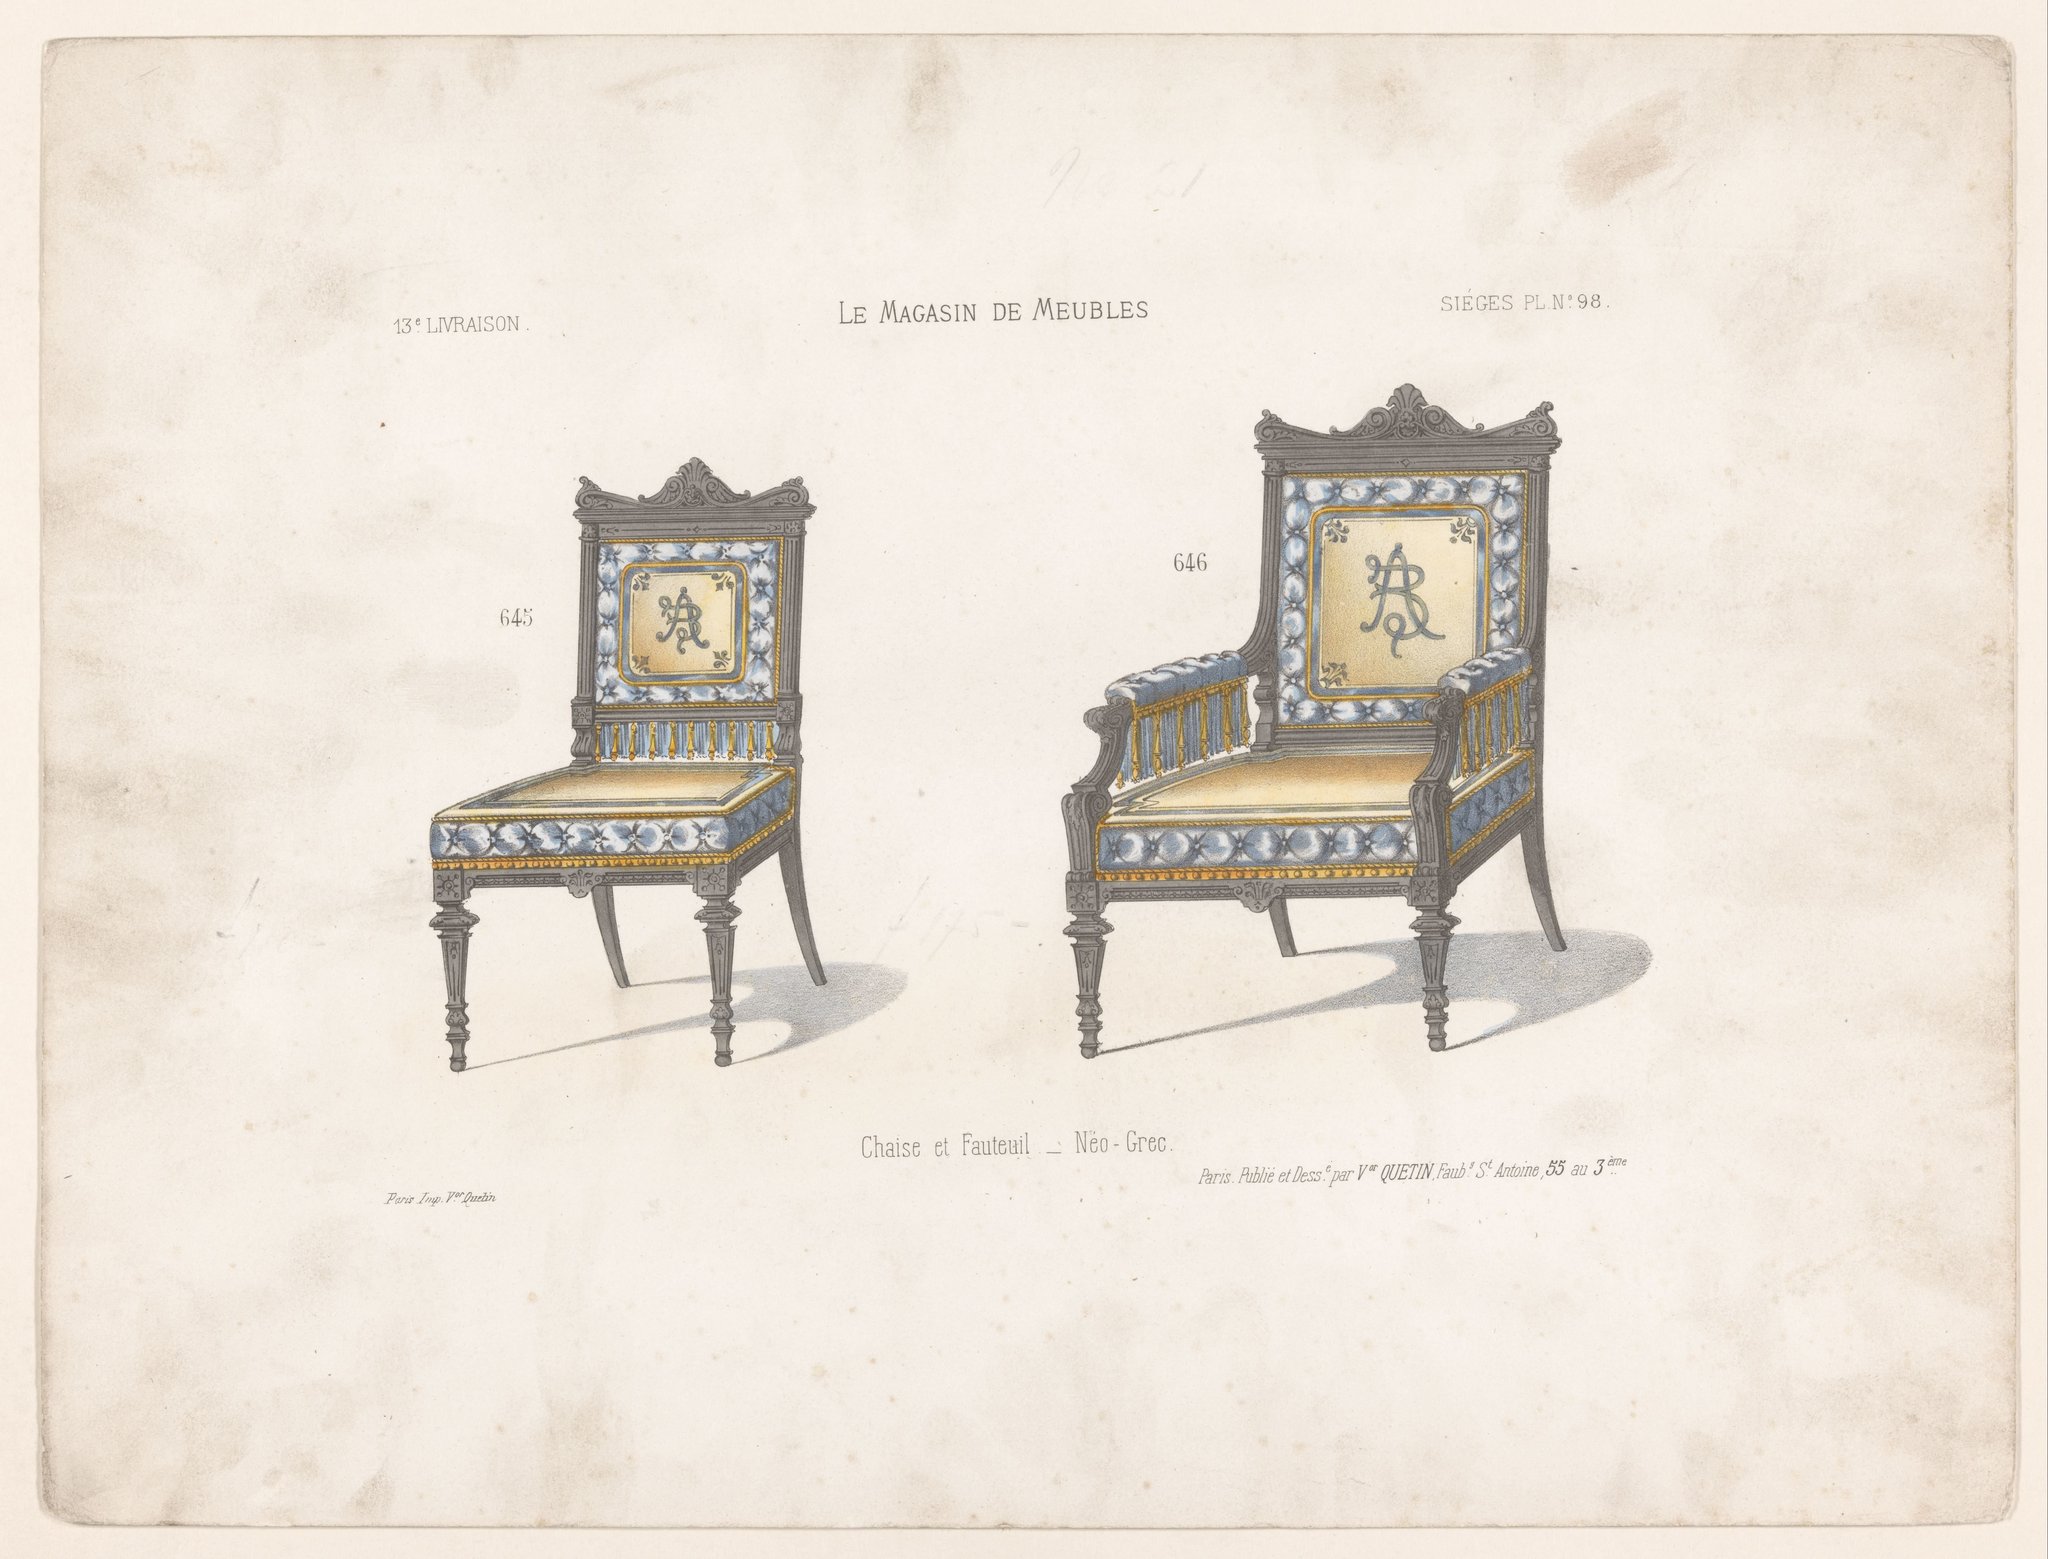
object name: print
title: Stoel en fauteuil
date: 1832-1877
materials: paper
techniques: hand coloring, lithograph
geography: paris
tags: seating furniture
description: Een stoel en fauteuil in de stijl van de neo-grec. Prent uit 13e Livraison.